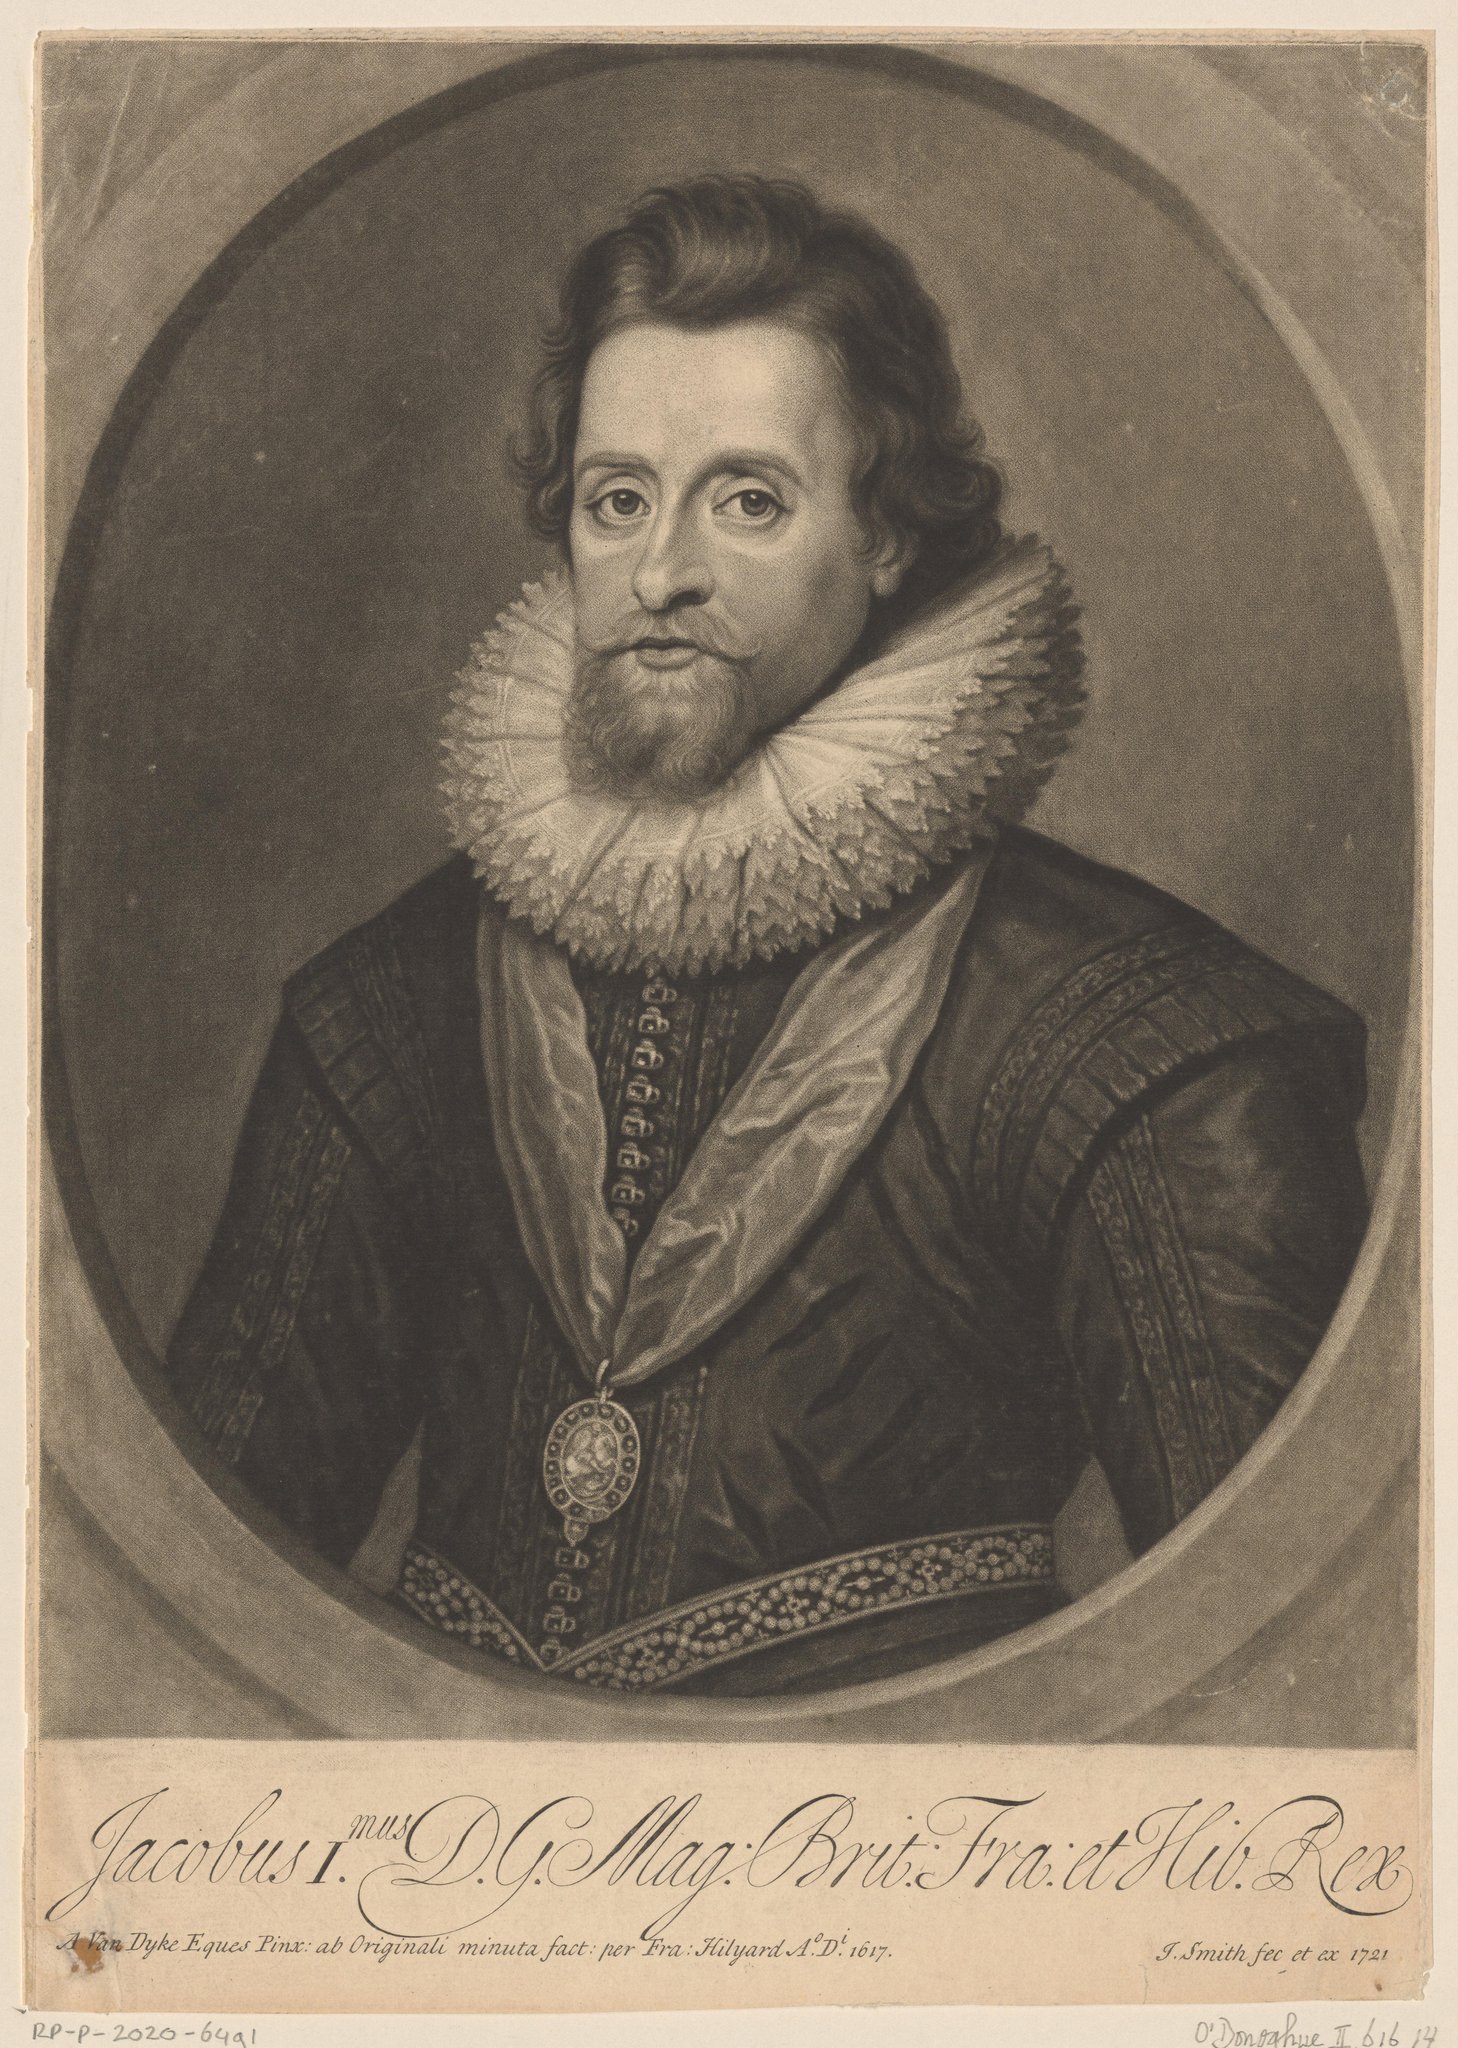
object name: print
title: Portret van Jacobus I, koning van Engeland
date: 1721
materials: paper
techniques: engraving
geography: london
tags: jacobus i (koning van engeland), historical persons, king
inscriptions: collector's mark: Lugt 240